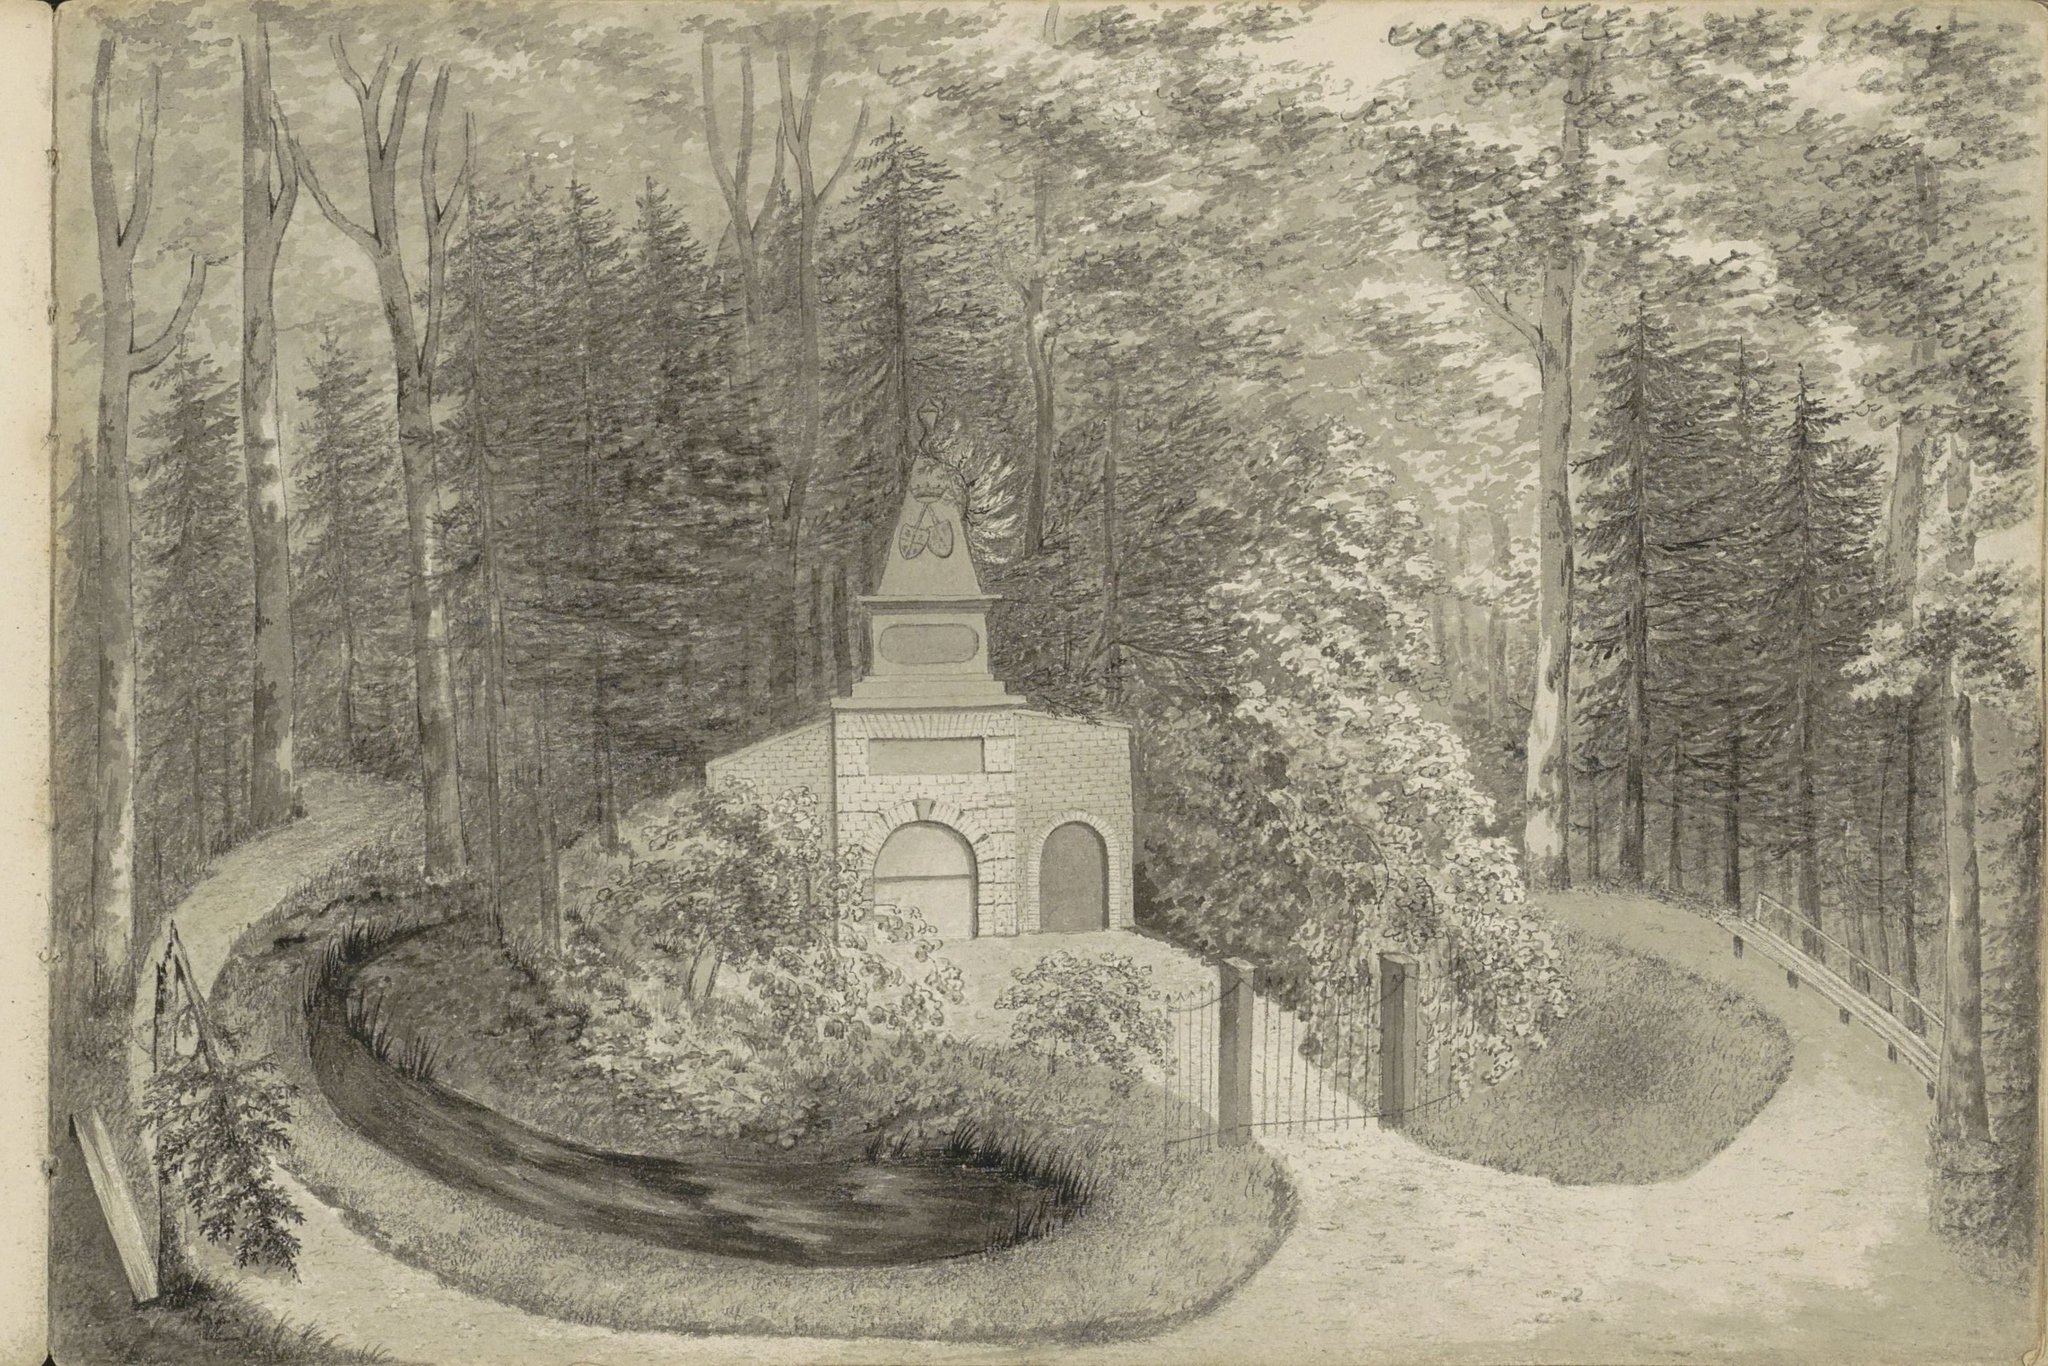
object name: sketchbook leaf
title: Monument in een bos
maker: Anonymous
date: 1839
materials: paper, pencil, watercolor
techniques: brush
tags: landscape with monument, forest, wood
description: Blad 6 recto uit een schetsboek met 45 bladen.